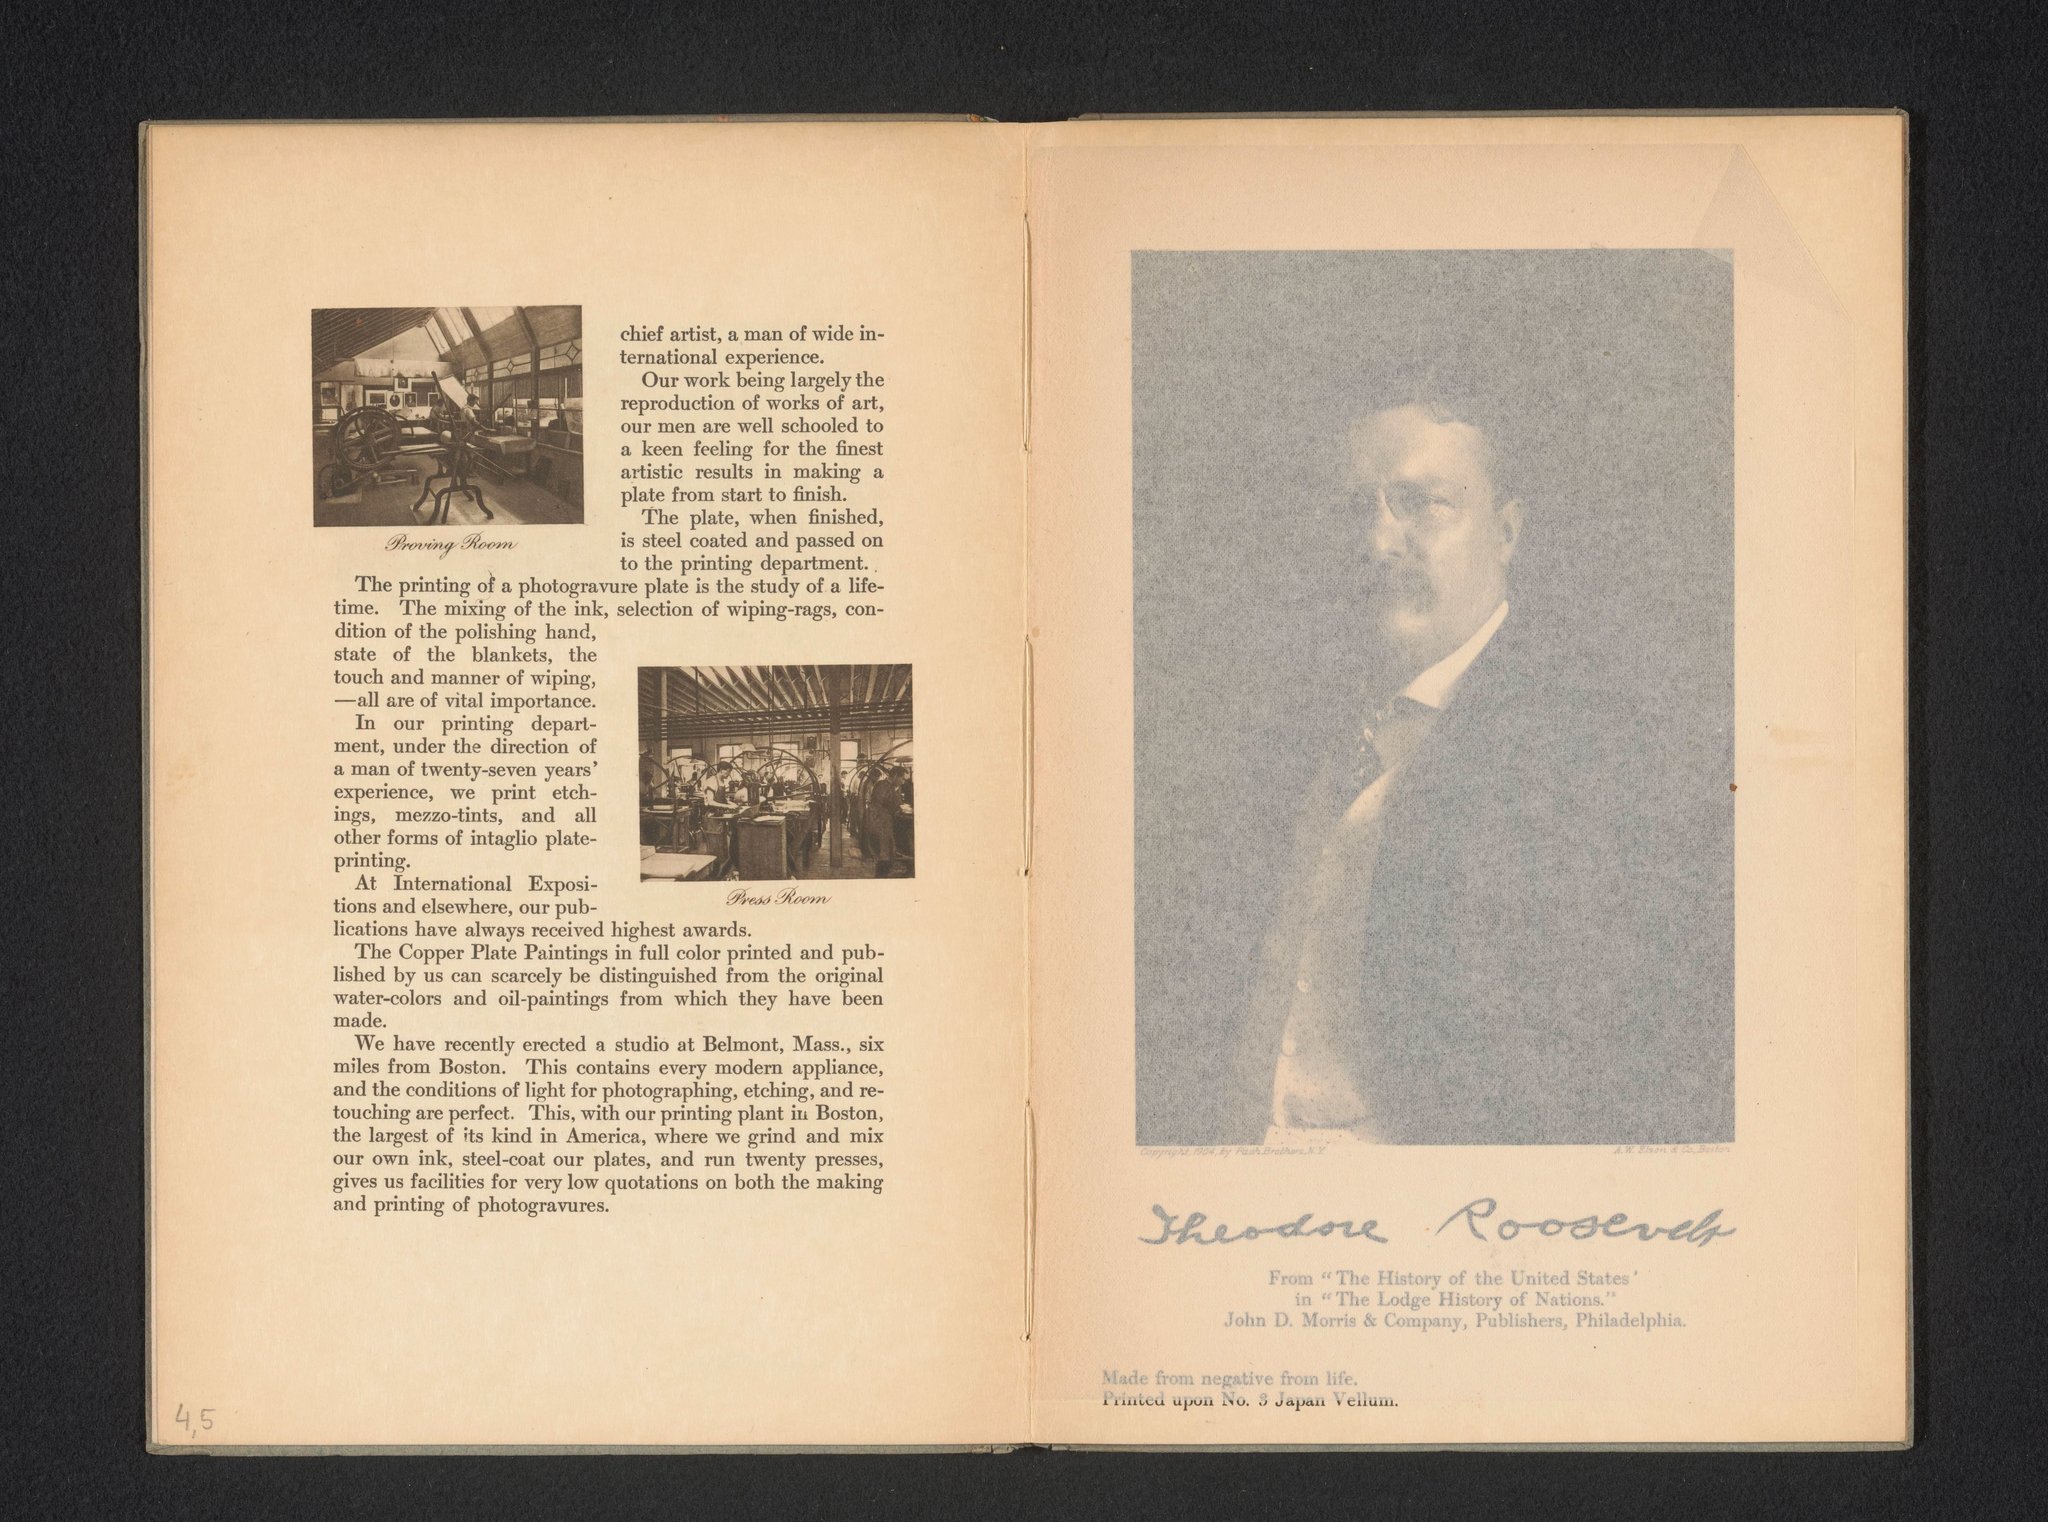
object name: page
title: Gezicht op een drukkerij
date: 1903-1908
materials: paper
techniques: photograph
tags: printing, printing office